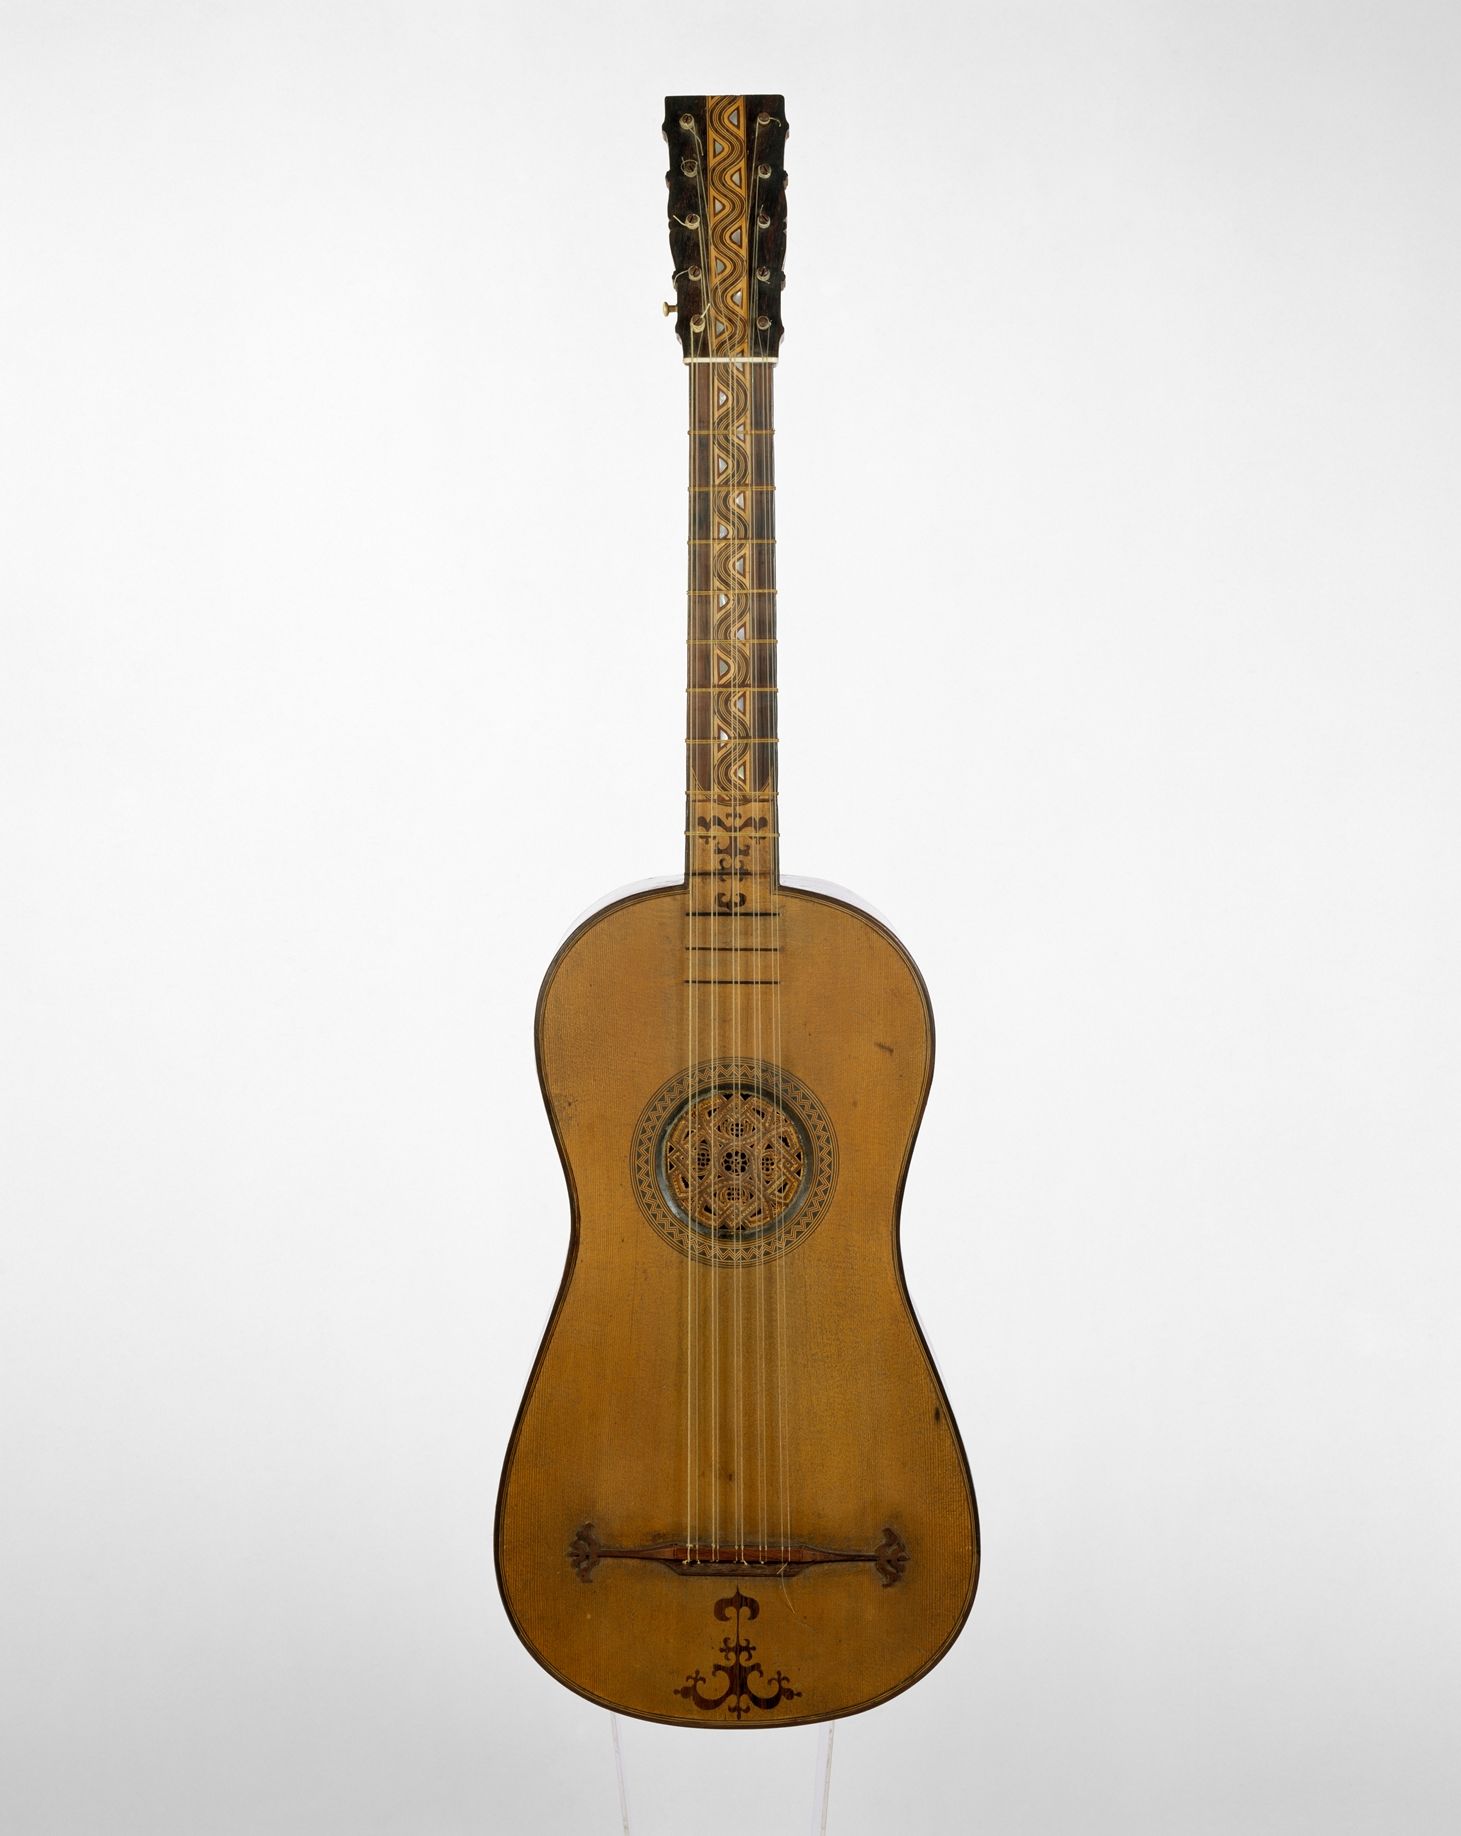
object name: guitar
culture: spanish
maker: josé massague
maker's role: maker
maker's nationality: spanish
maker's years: 1690-1764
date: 1755-1760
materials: ivory, wood, mother of pearl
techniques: bookbinding, inlay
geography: spain